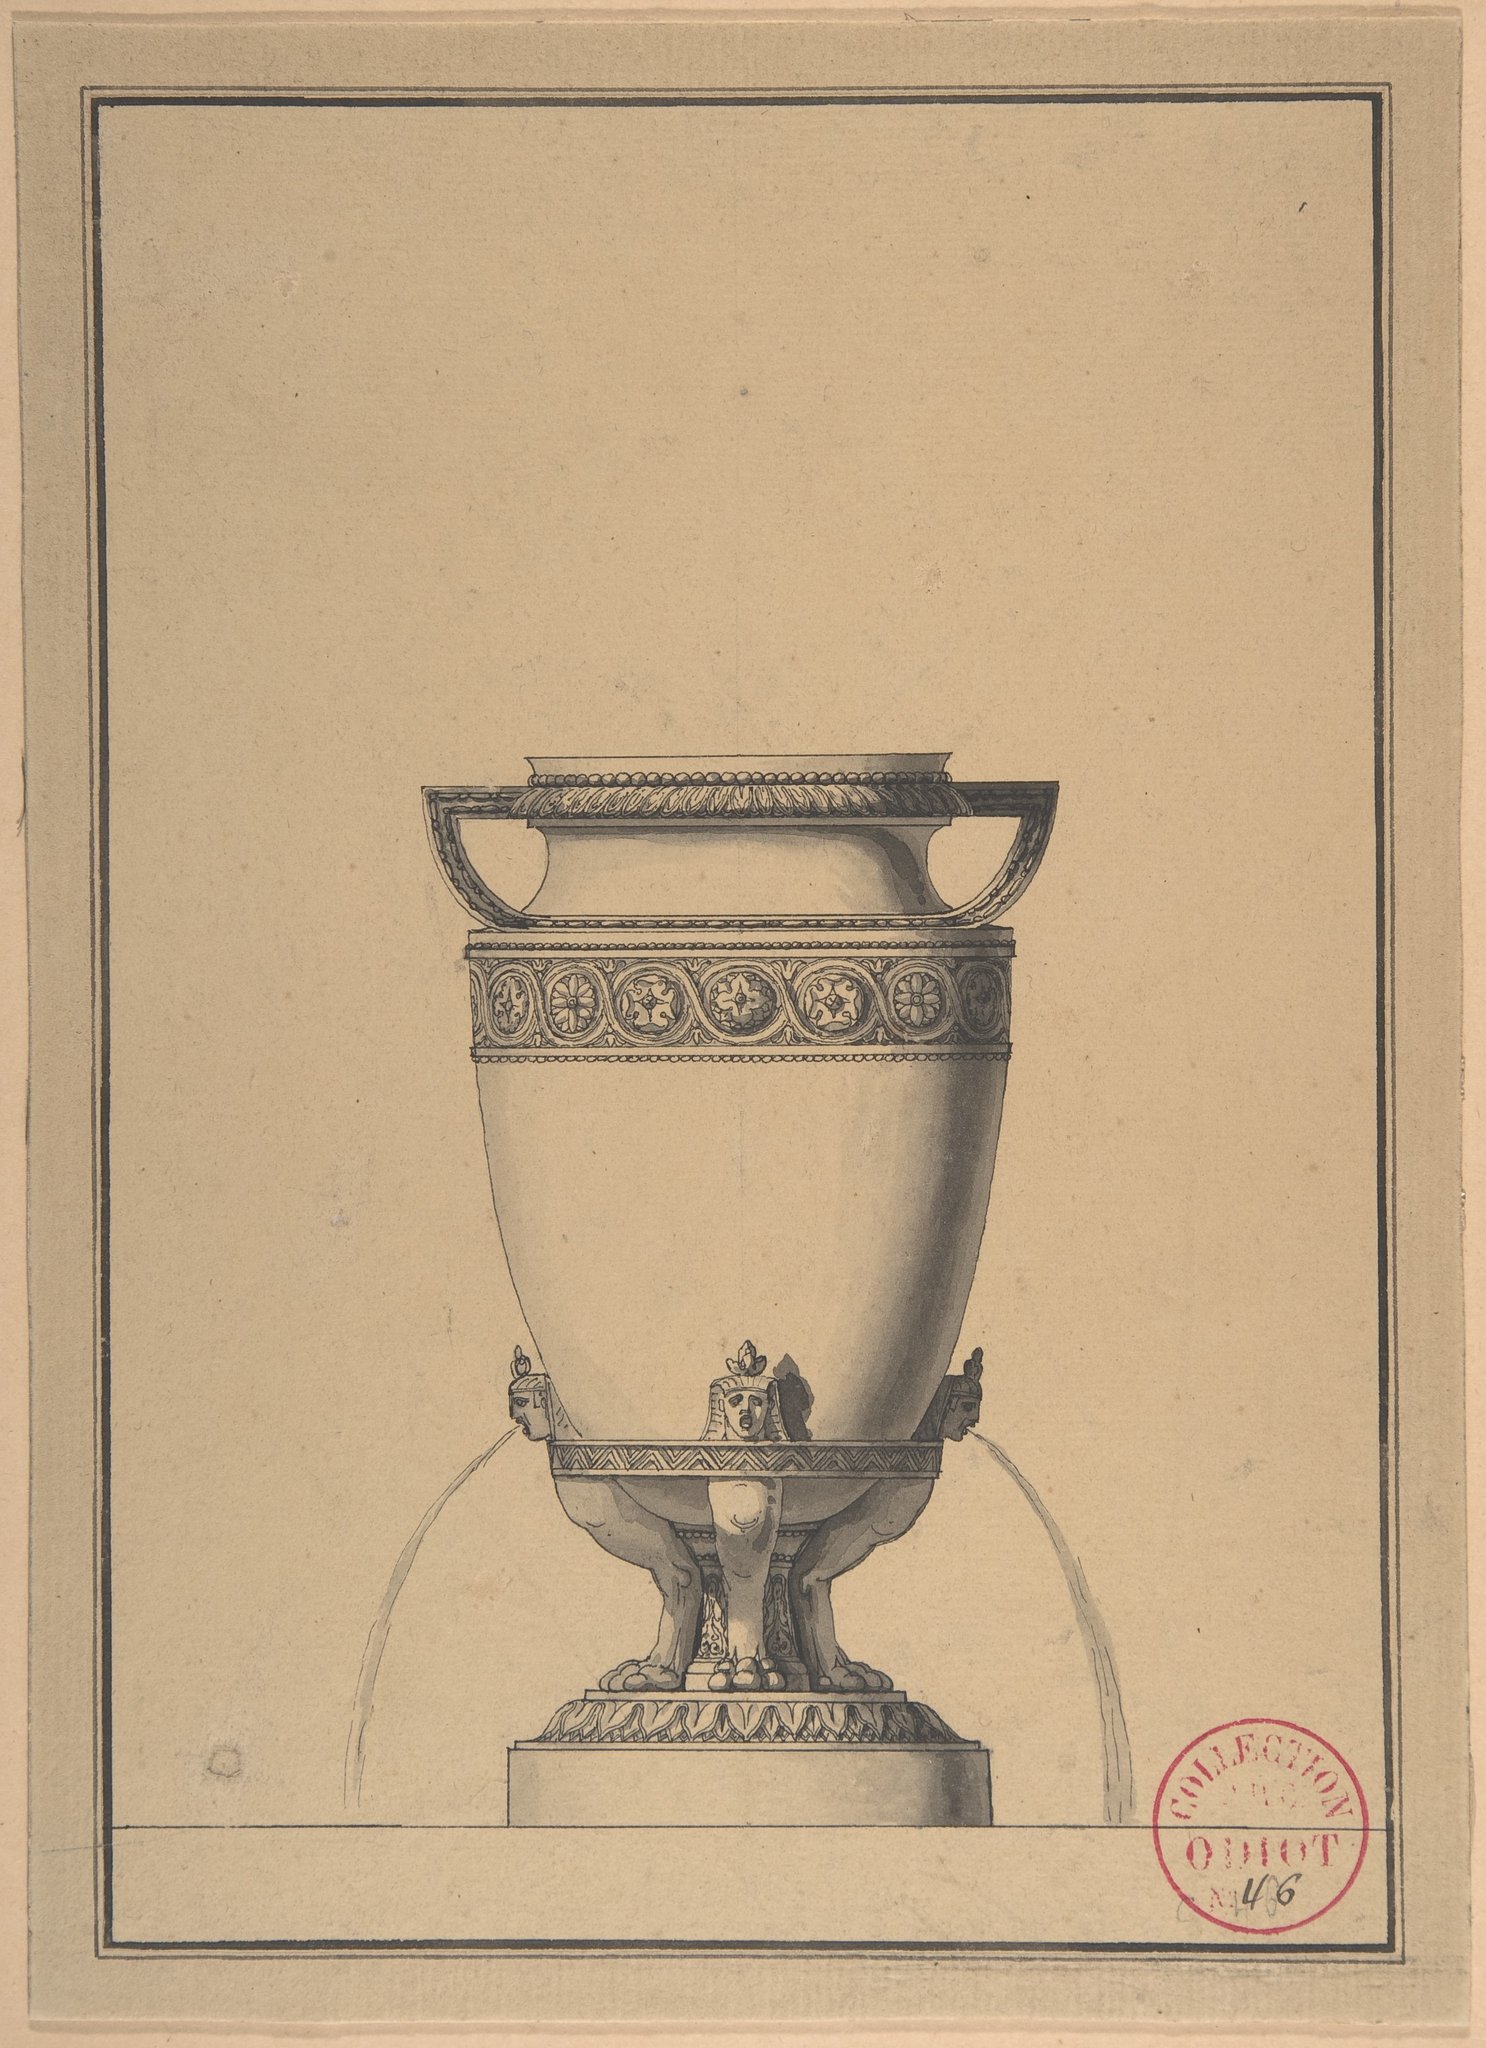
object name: drawing collection ornament architecture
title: Design for a Wine Fountain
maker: henri auguste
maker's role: artist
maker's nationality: french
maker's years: 1759-1816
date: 1770-1816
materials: ink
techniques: brush, pen, wash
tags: fountains,faces